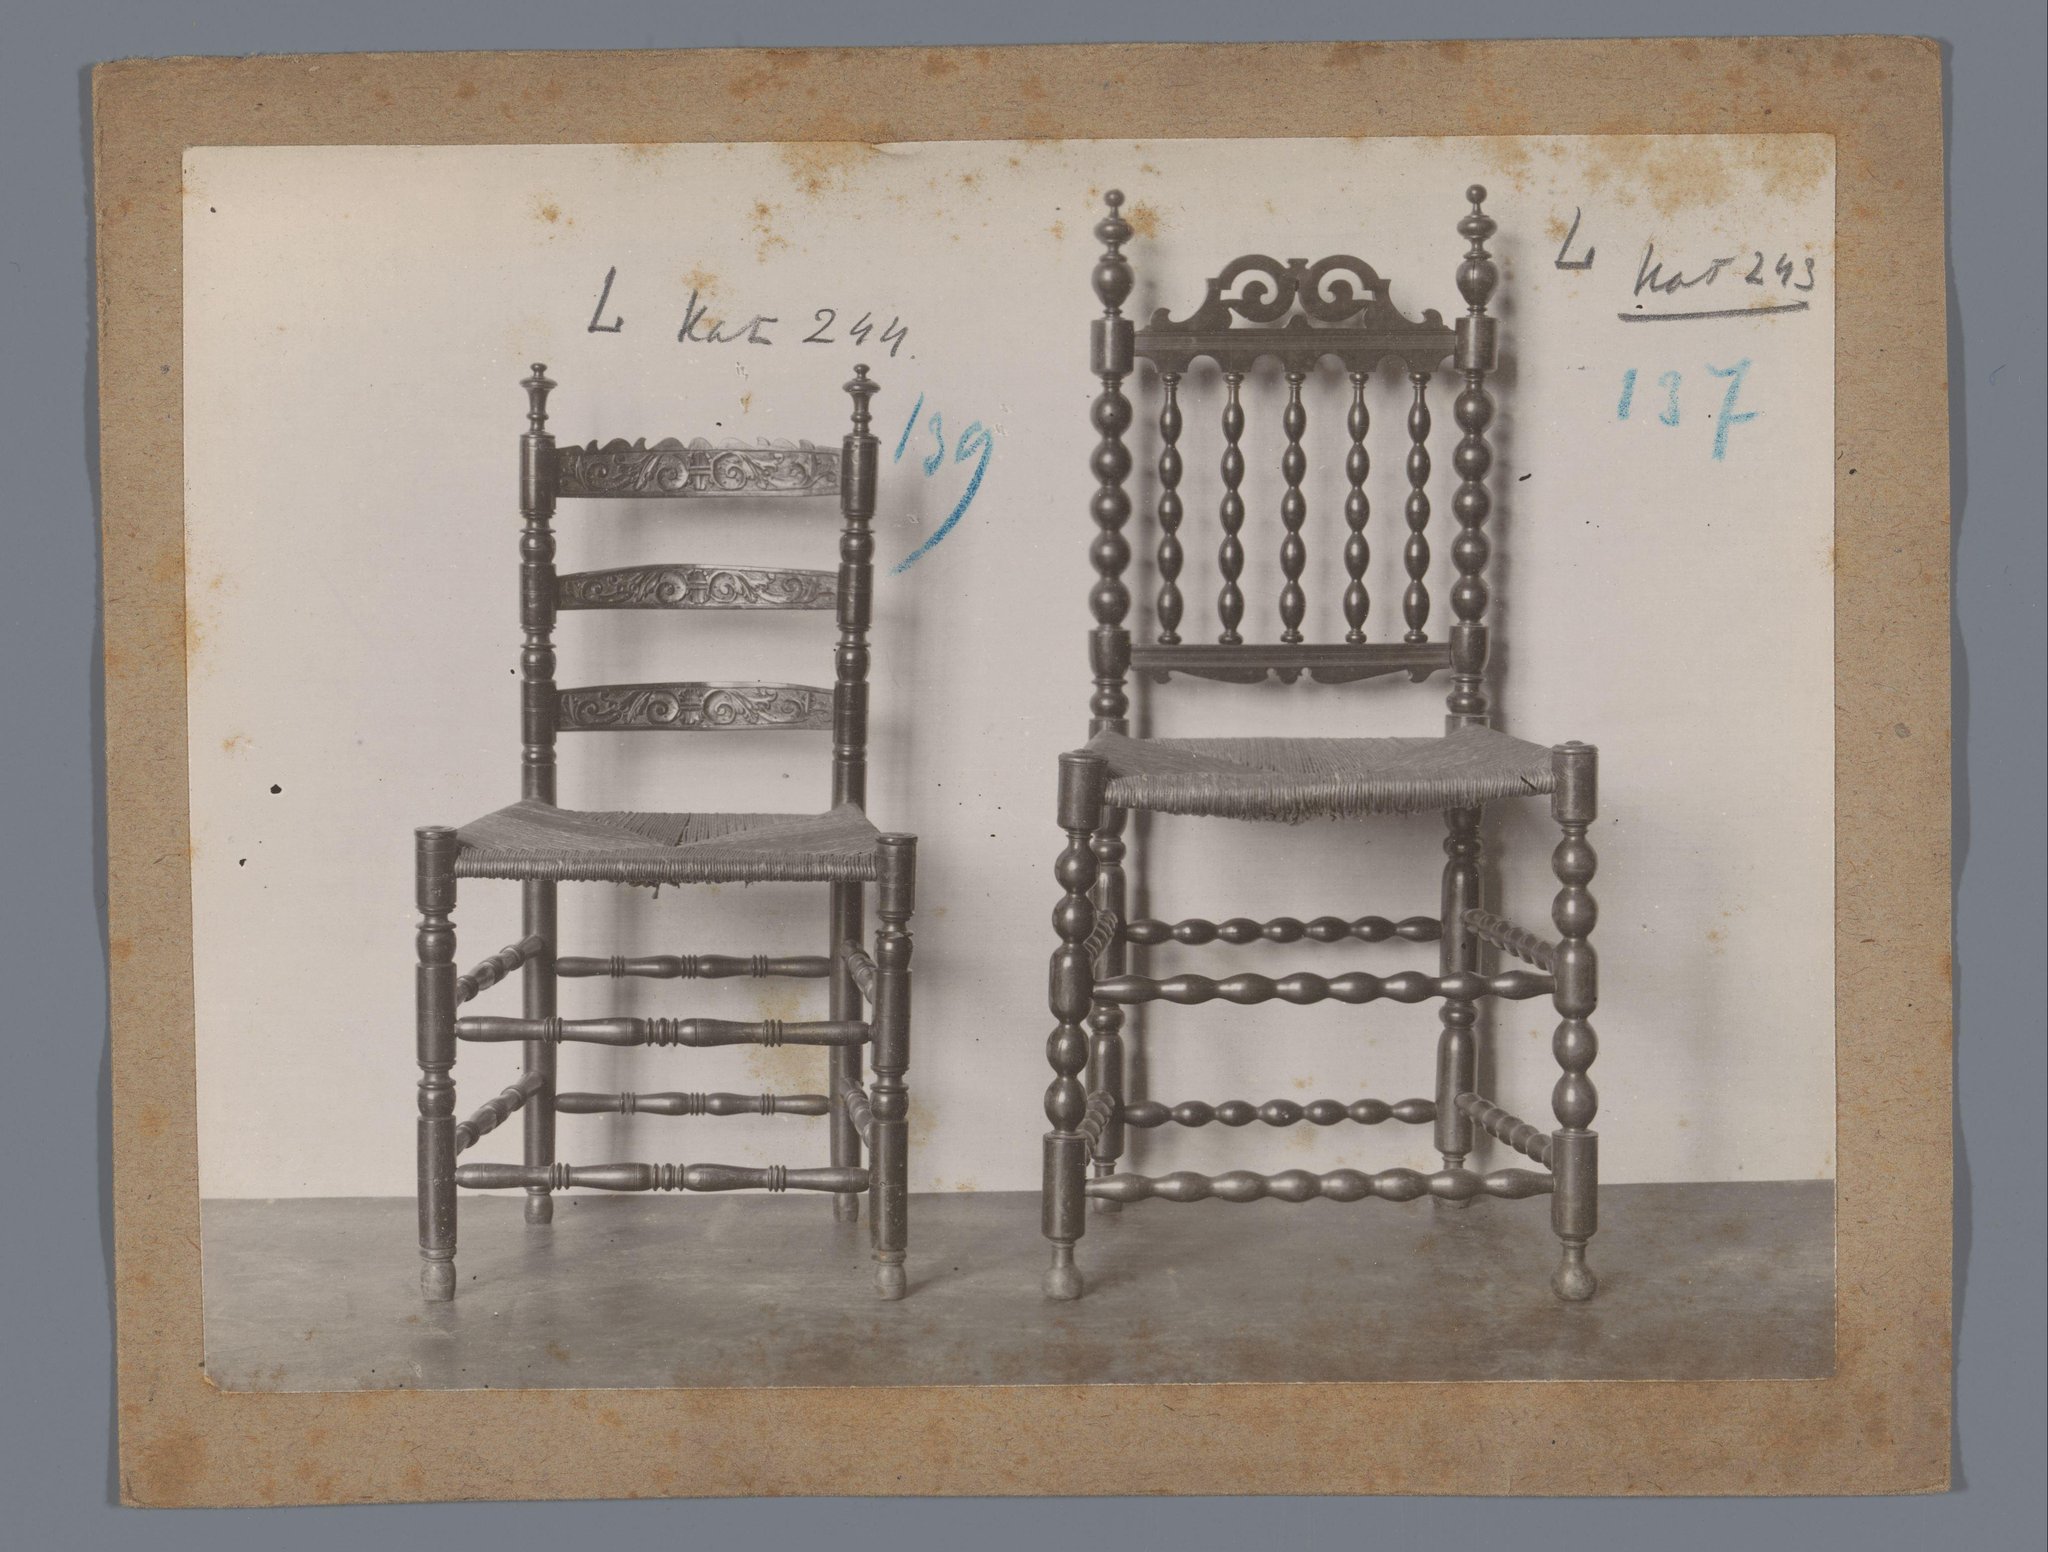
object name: photograph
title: Twee stoelen met een opengewerkte rug, bewerkte spijlen en een rieten zitting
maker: Anonymous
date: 1875-1900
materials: photographic support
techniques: matte daylight collodion silver print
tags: chair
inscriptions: collector's mark: ‘Instituut voor kunst-nijverheidsonderwijs Gabriël Metsustraat No. 16, Amsterdam’, number: ‘L kat 244 139 L kat 243 137’